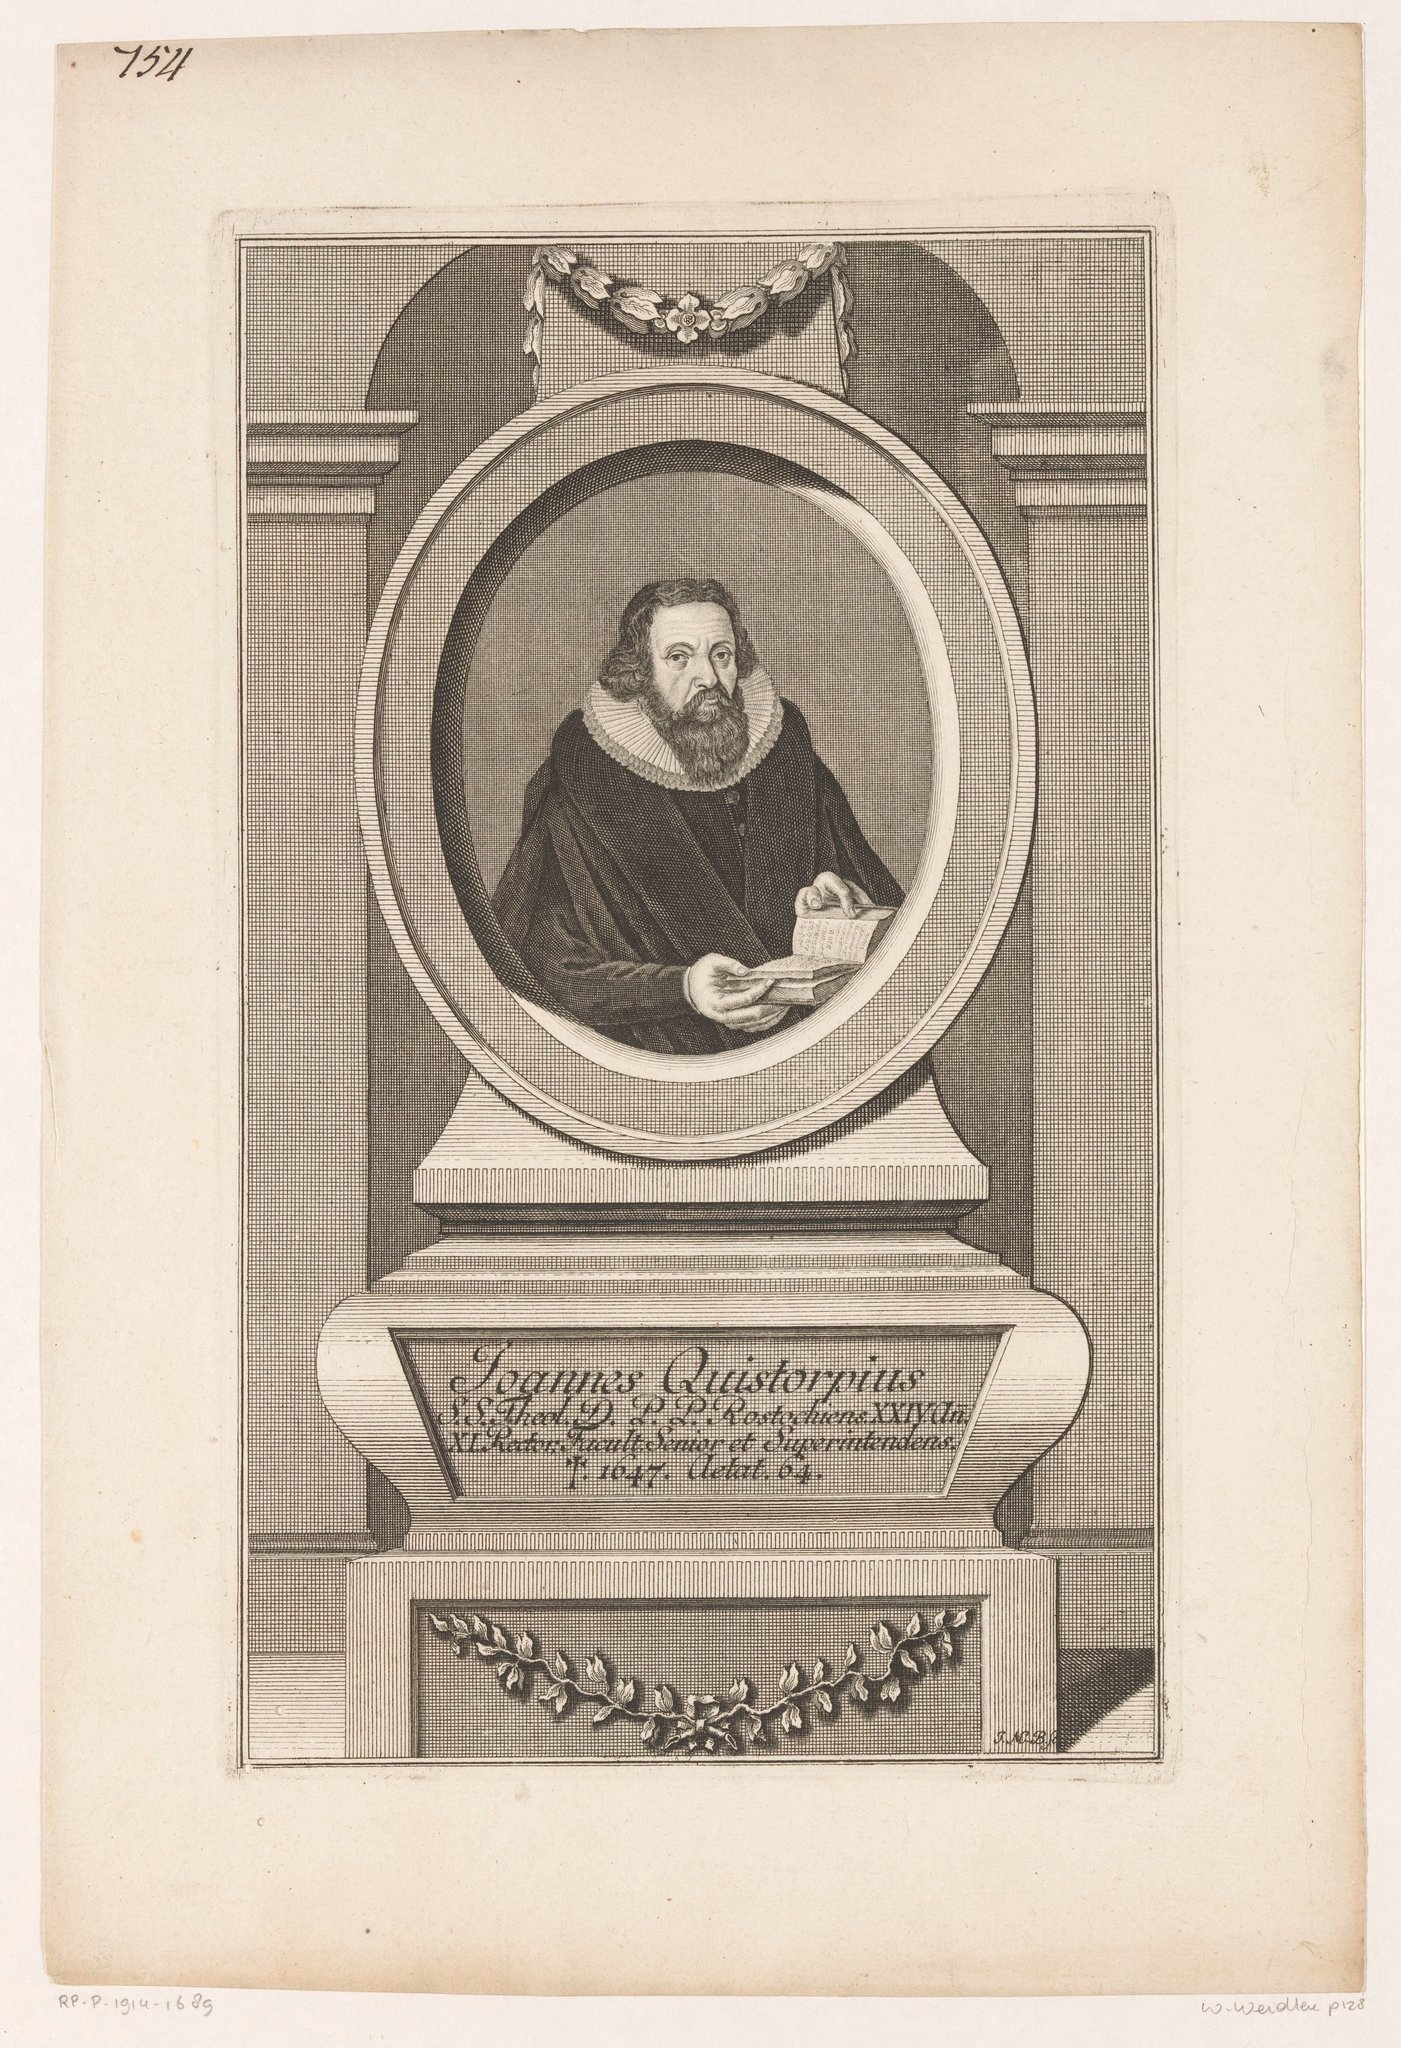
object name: print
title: Portret van Johann Quistorp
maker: johann martin bernigeroth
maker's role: print maker, publisher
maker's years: 1713-1767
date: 1743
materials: paper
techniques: engraving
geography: leipzig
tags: historical persons, book - mm - book open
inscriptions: collector's mark: Lugt 2228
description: Een andere staat van deze prent is gebruikt in: Westphalen, Ernst Joachim von. Monumenta Inedita Rerum Germanicarum Praecipue Cimbricarum Et Megapolensium (...). 4 dln. Leipzig: Johann Christian Martini, 1739-1745, dl. 3 (1743), na p. 1258.